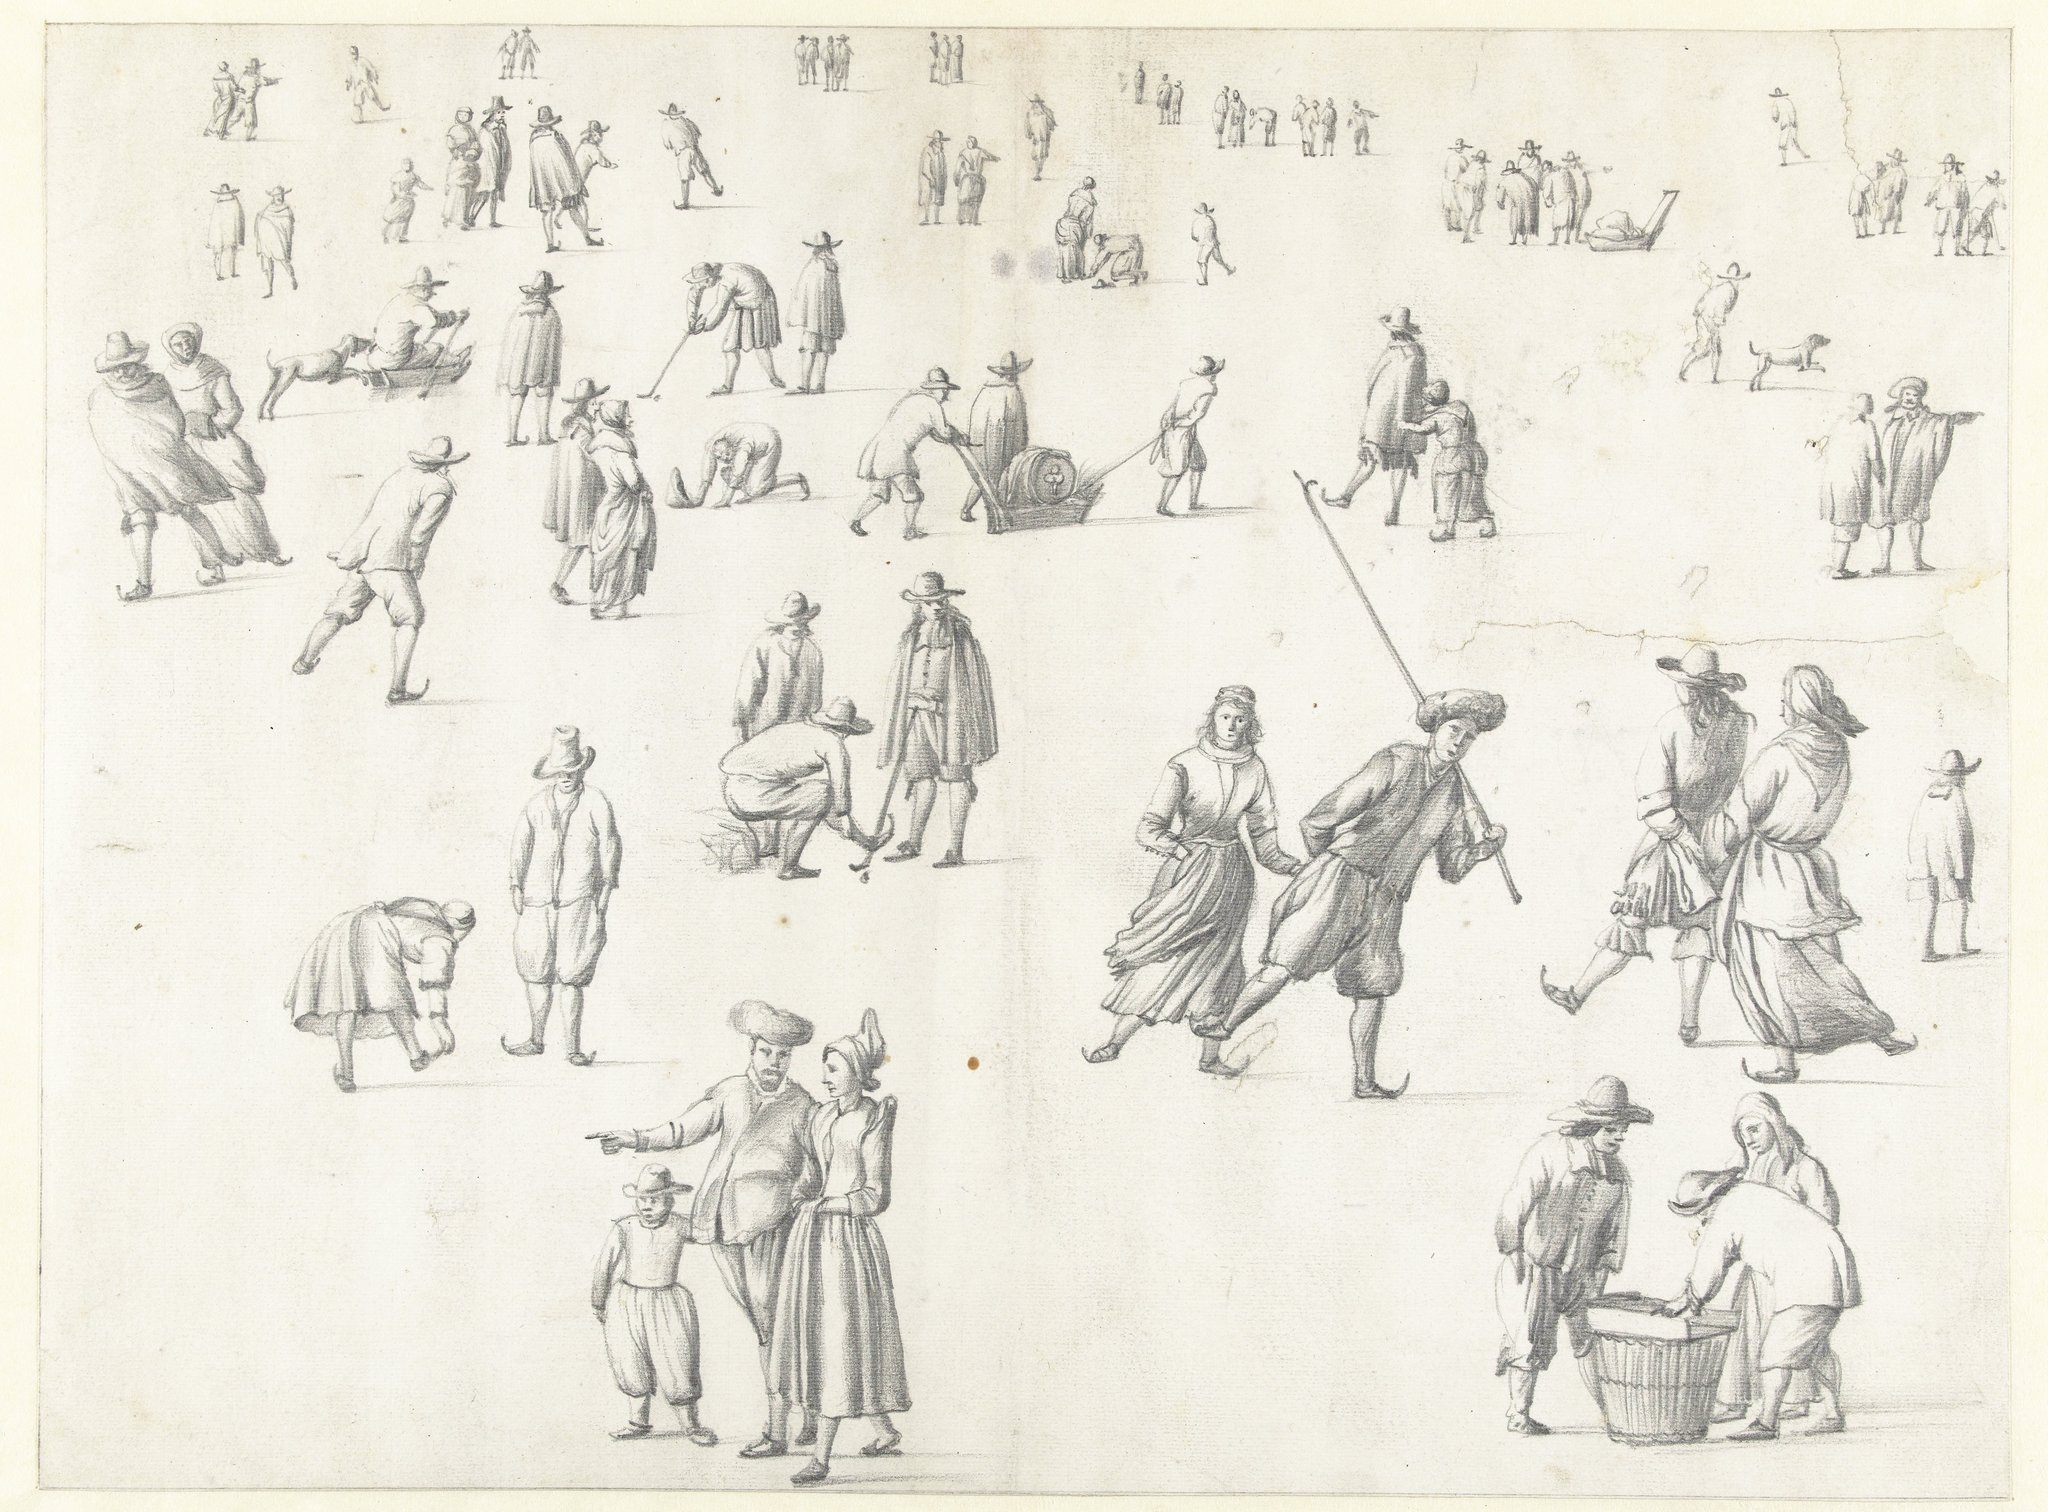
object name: drawing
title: Groups of Figures on the Ice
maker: jan abrahamsz. beerstraten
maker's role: draughtsman, painter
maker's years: 1622-1666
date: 1600-1699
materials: chalk, graphite, paper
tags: sleigh, sledge (non-sport), skates (winter sports)